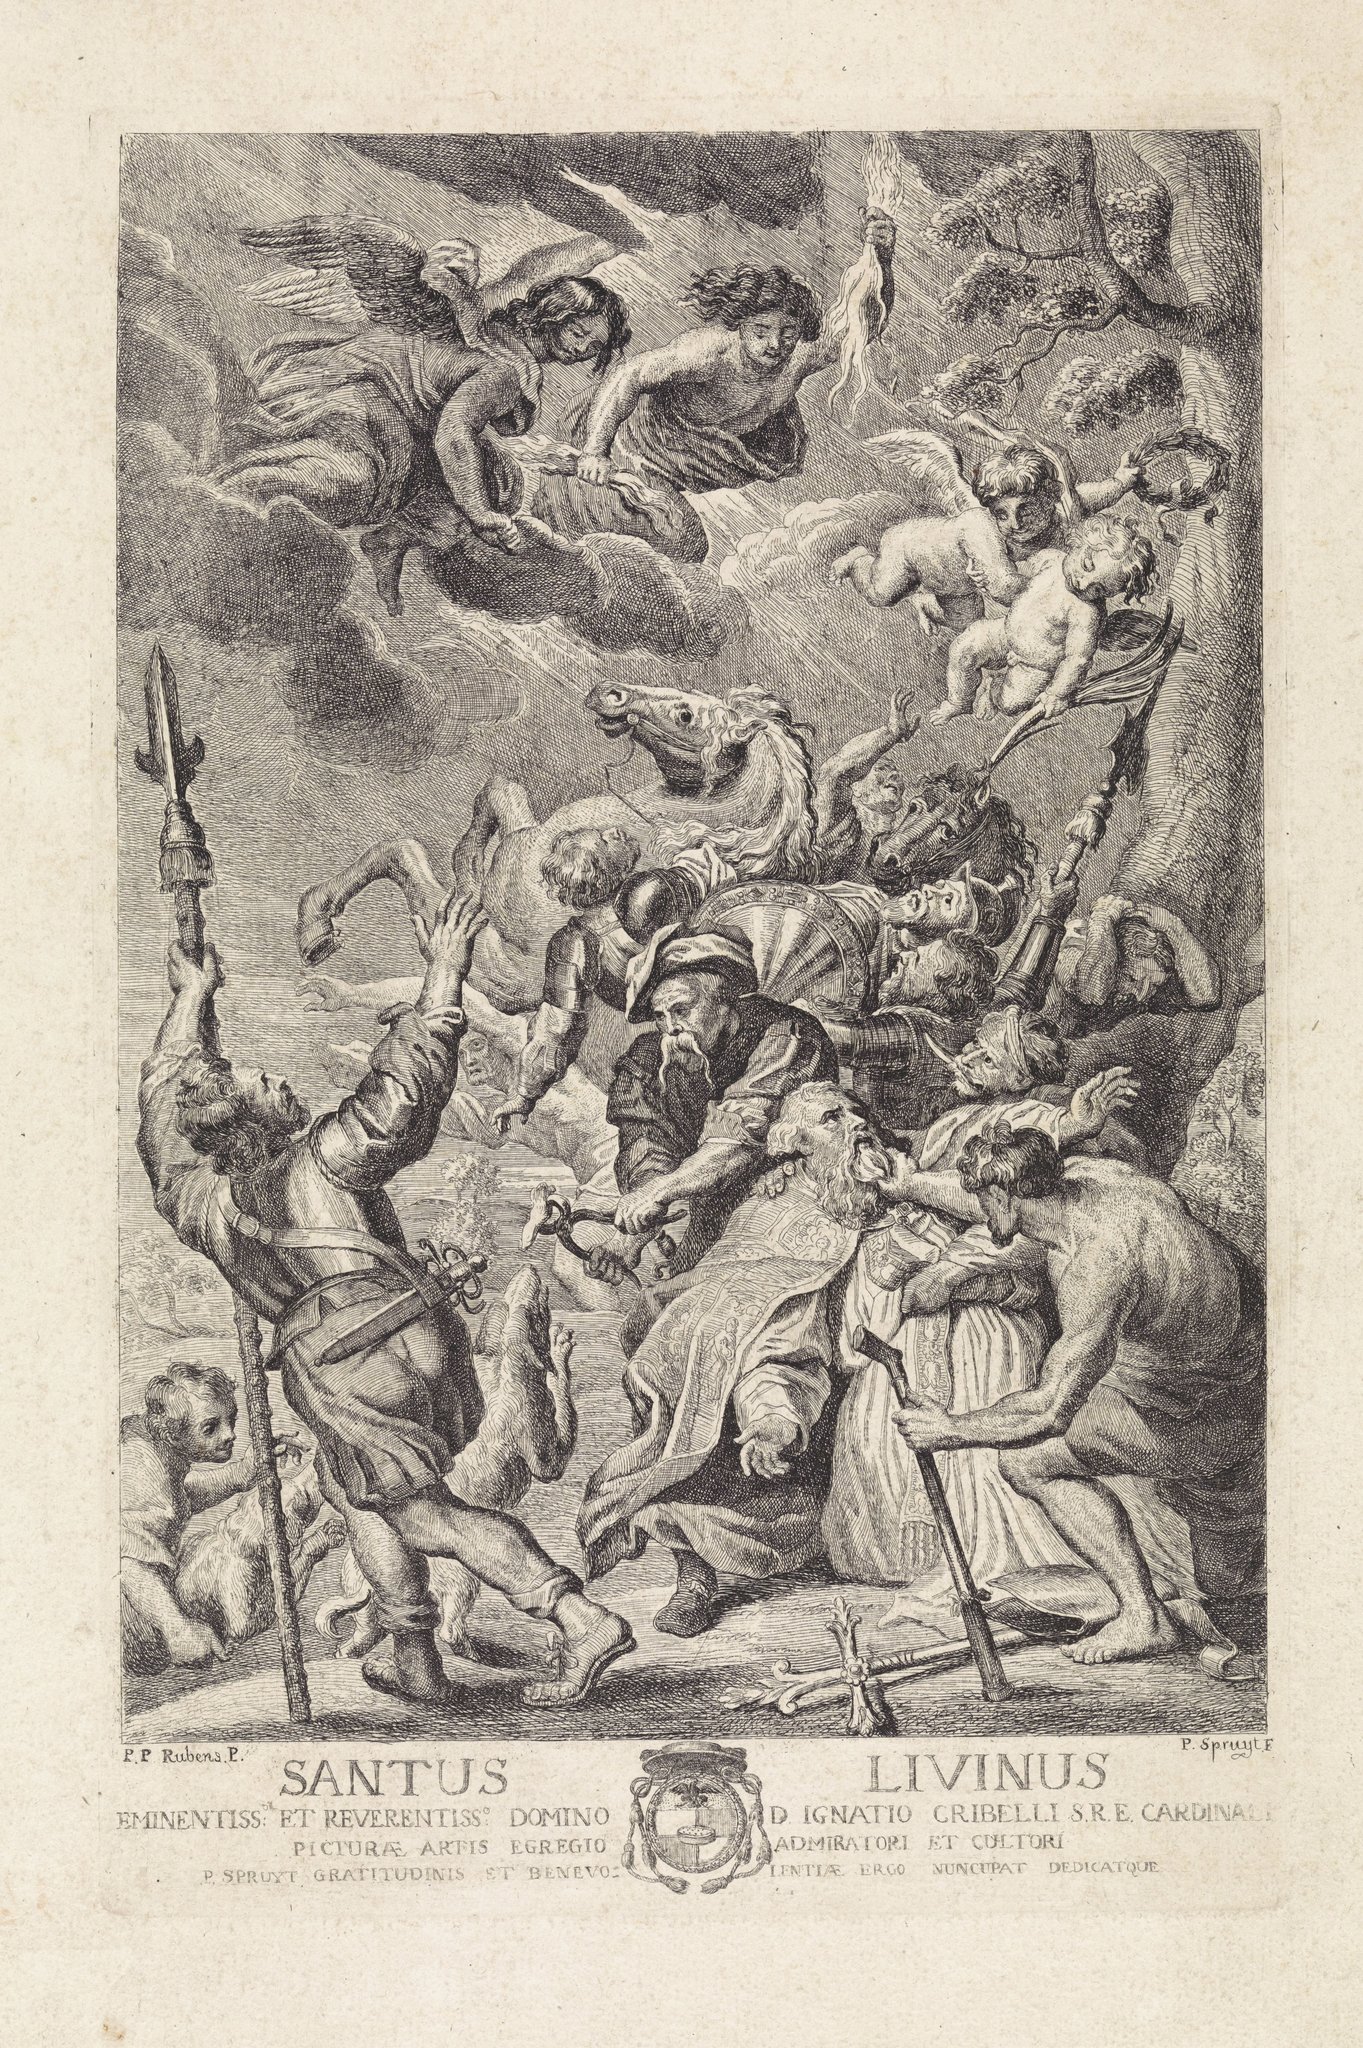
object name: print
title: Martelaarschap van de H. Livinus van Gent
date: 1747-1801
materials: paper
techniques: etching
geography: ghent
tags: martyrdom, suffering, misfortune, death of st. livinus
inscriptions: collector's mark: Lugt 2228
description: De tong van de heilige Livinus is uitgerukt. Een beul houdt hem bij de baard vast, een andere man houdt de tang met de tong vast. Het paard op de achtergrond en de soldaten schrikken als aan de hemel engelen verschijnen en een mannelijke figuur het laat bliksemen. Midden onder een opdracht in het Latijn aan en het wapenschild van kardinaal Ignazio Michele Crivelli.